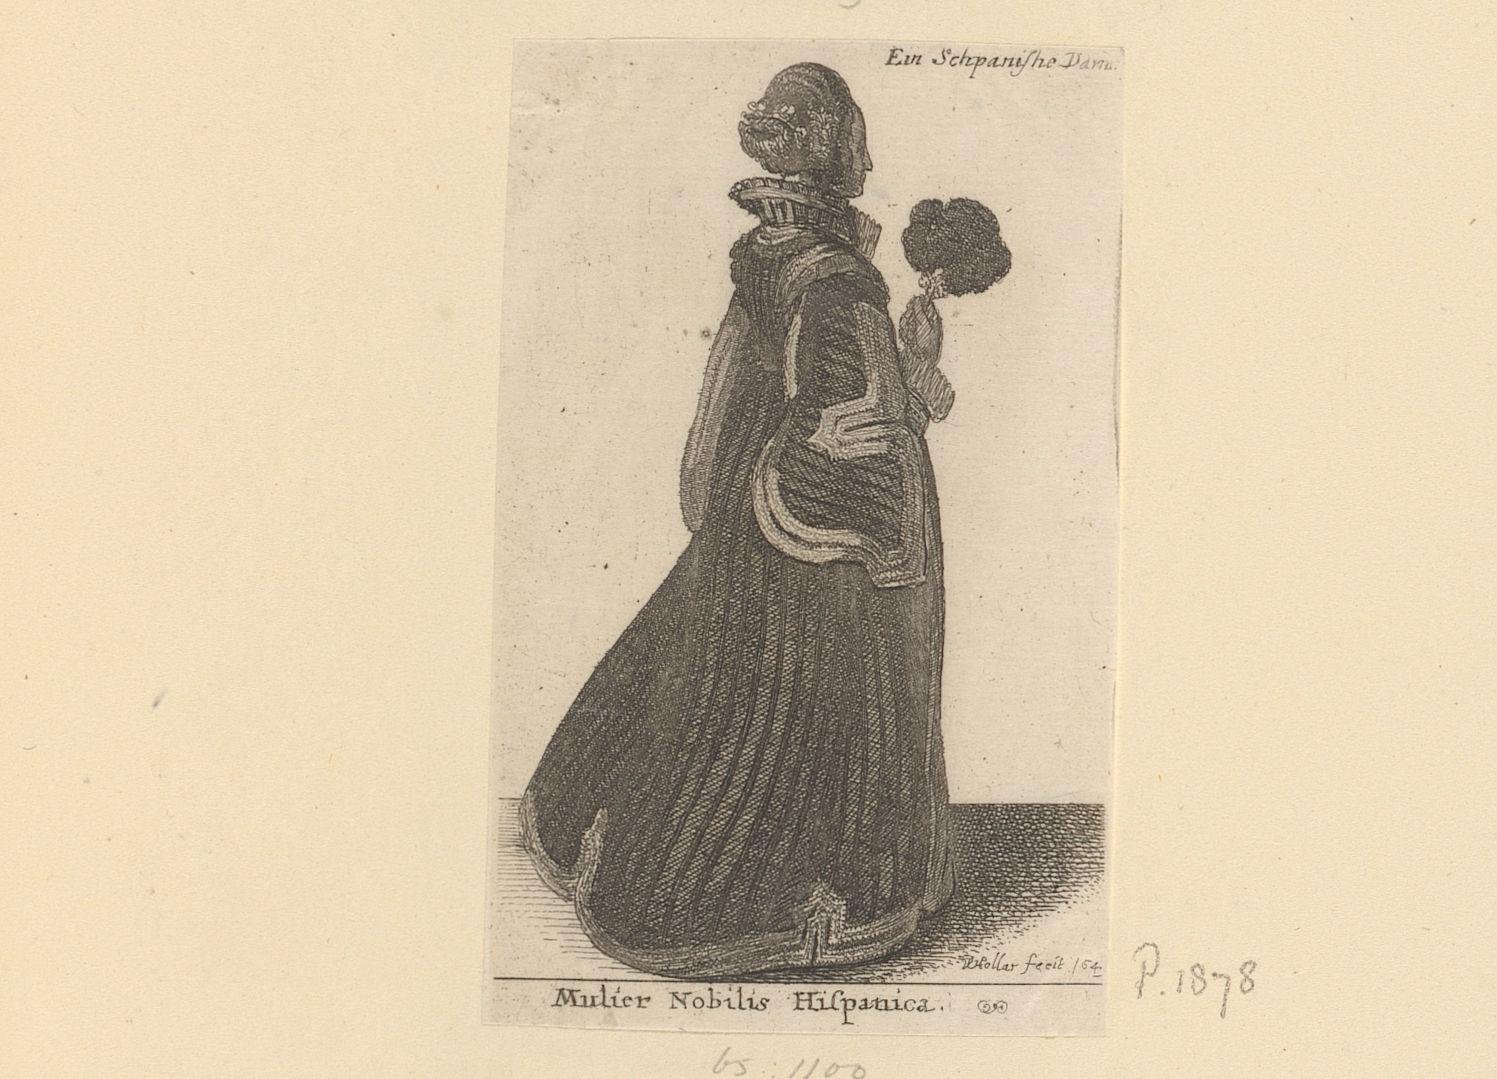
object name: print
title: Vrouwelijke klederdrachten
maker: wenceslaus hollar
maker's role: draughtsman, print maker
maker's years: 1607-1677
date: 1649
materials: paper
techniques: etching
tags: adult woman, folk costume, regional costume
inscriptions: date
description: Prent maakt mogelijk deel uit van een serie van 200 prenten. Deze serie is onder de titel 'A Collection of two hundred original etchings' voor het eerst uitgegeven door J.M. Greery in 1816.